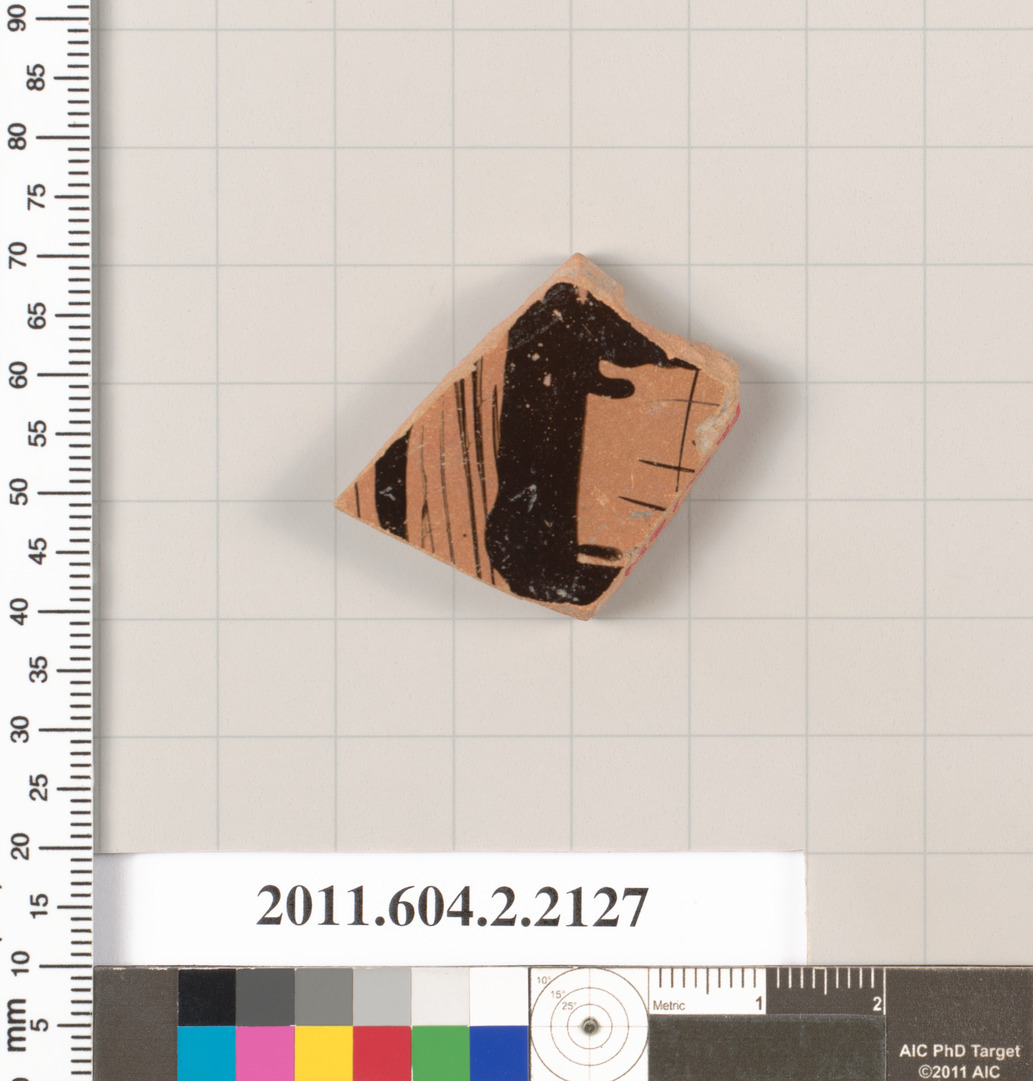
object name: pot fragment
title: Terracotta fragment of a pot; glazed on the inside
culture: greek, attic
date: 467-435 BCE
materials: terracotta